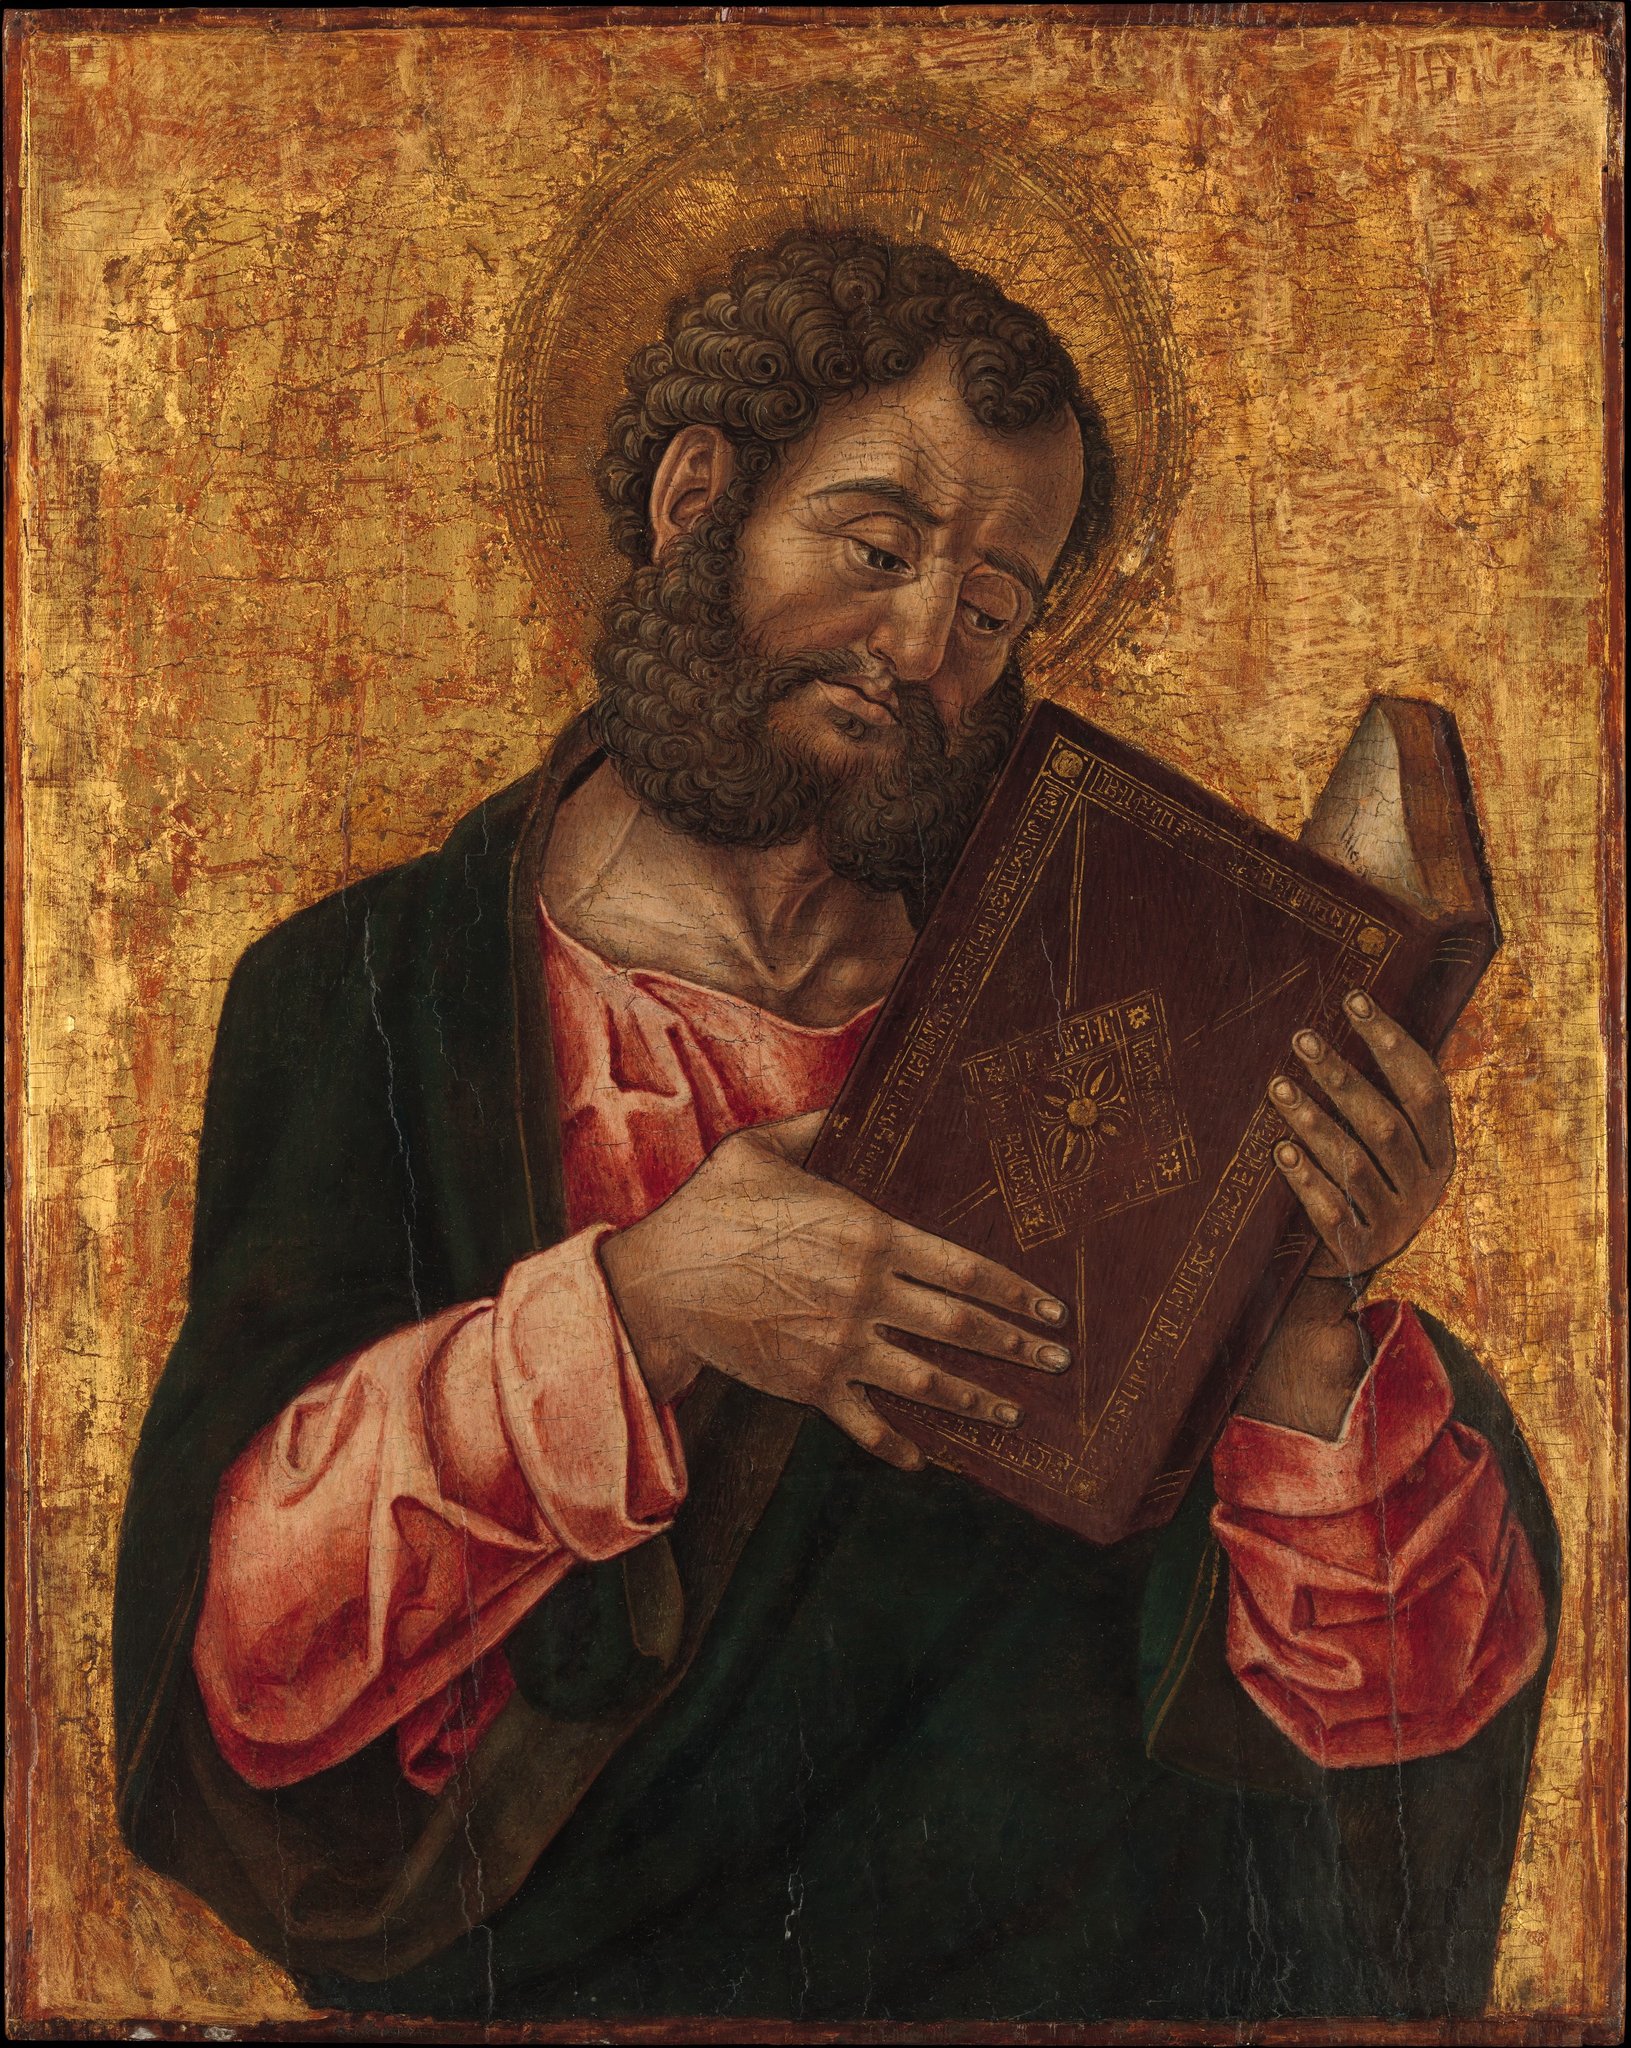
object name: painting fragment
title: A Saint (Mark?) Reading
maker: bartolomeo vivarini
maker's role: artist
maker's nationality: italian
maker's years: 1450-1491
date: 1470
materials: gold leaf, paint, wood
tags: men,reading,saint mark